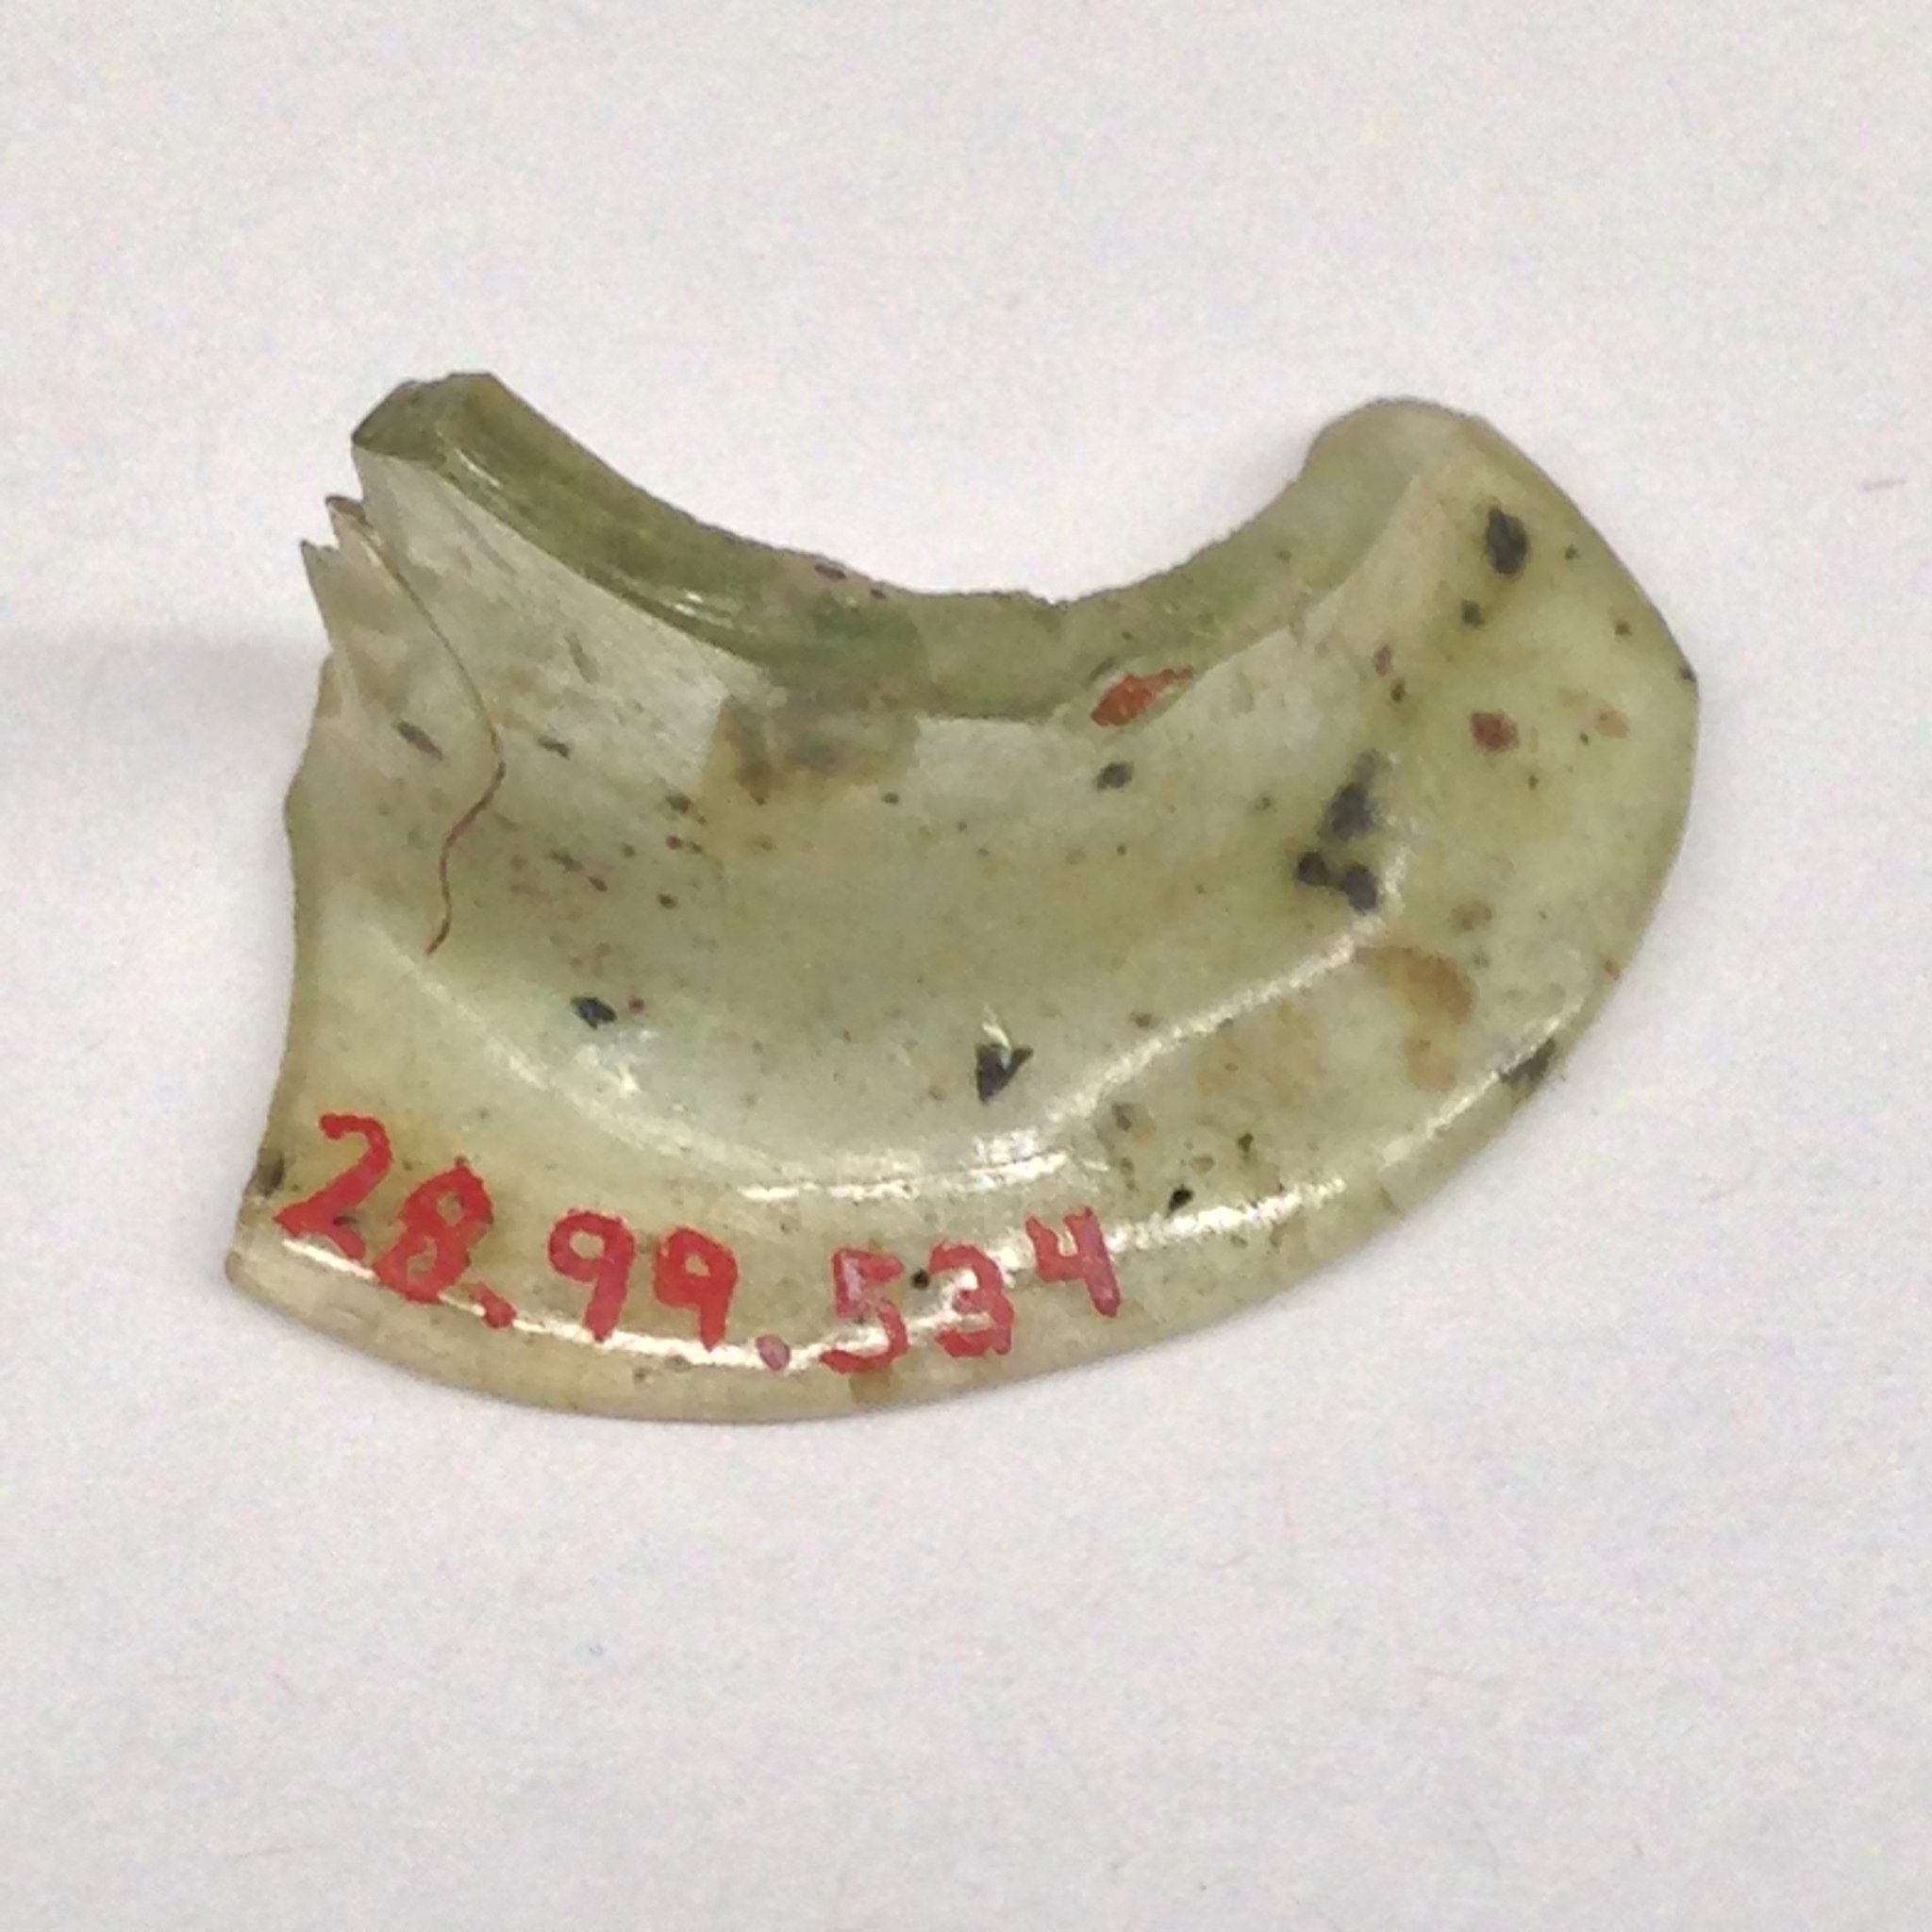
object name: fragment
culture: european or middle eastern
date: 1150-1250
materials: ceramic, glass